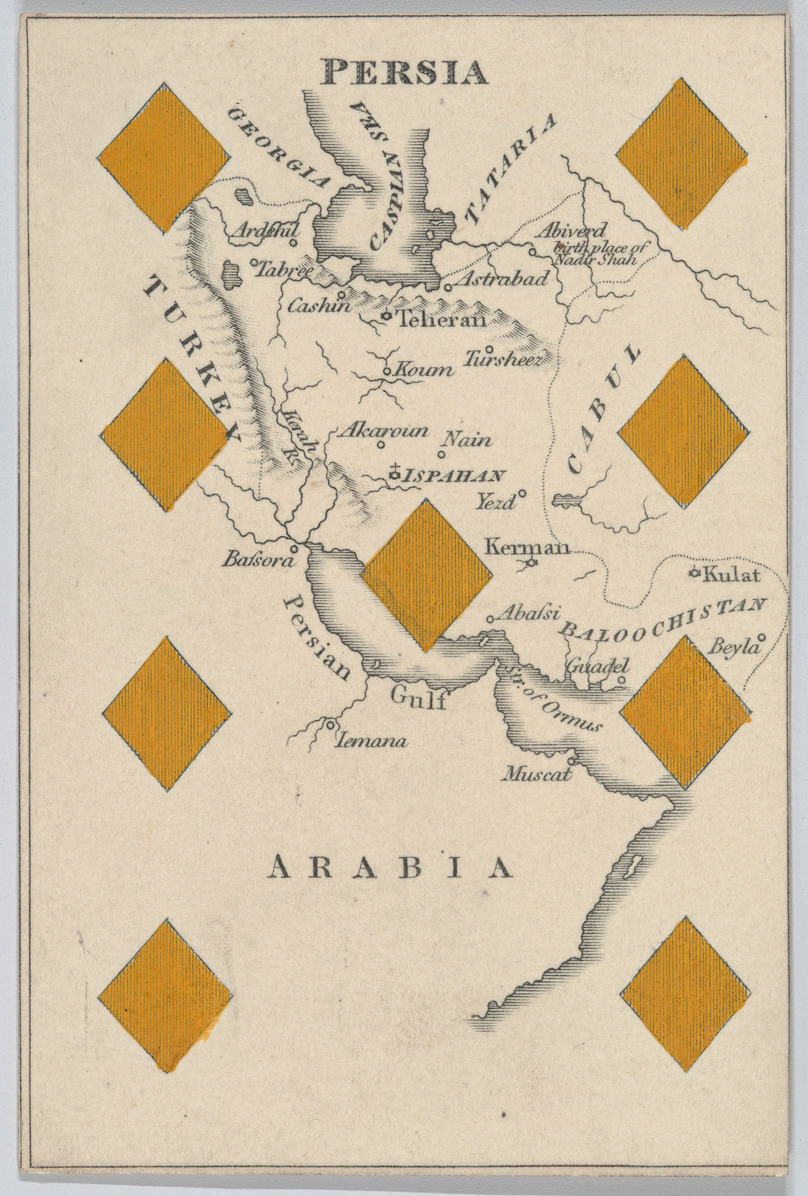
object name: print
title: Persia in Asia, from "Court Game of Geography"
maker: william and henry rock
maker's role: publisher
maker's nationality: british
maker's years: 1821-1884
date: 1838-1855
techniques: engraving, hand coloring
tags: playing cards,maps